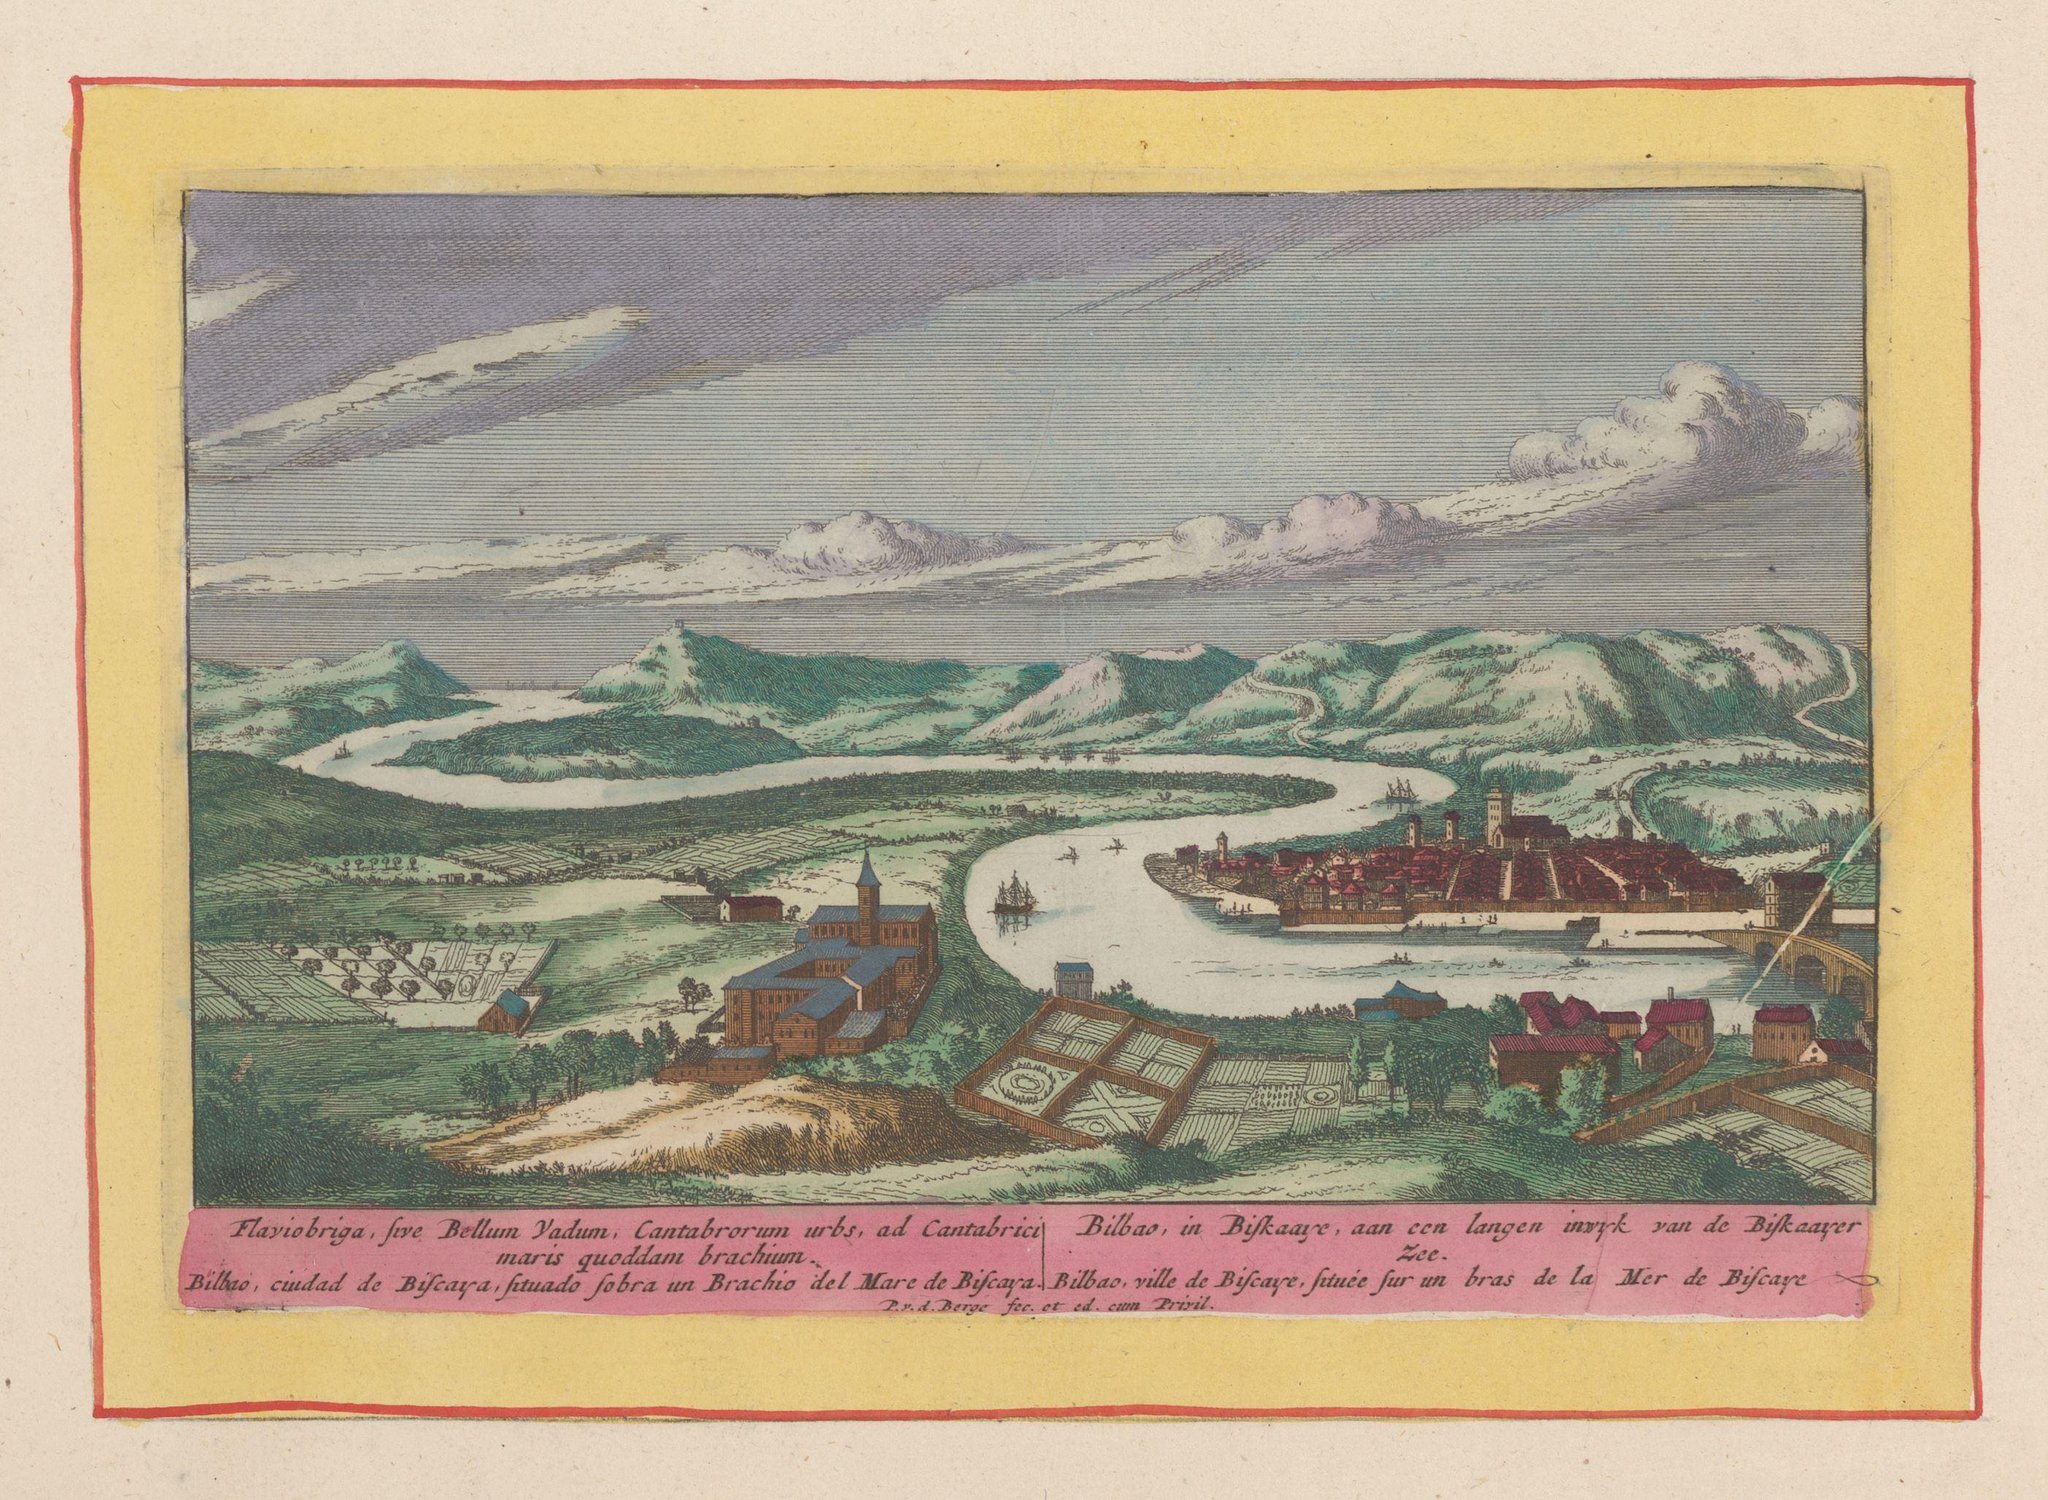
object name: book illustration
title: Bilbao, in Biskaaye, aan een langen inwyk van de Biskaayer Zee (...)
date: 1694-1737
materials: paper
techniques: etching, hand coloring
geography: the hague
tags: prospect of city, town panorama, silhouette of city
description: Prent uit: Theatrum Hispaniæ, exhibens regni urbes, villas ac viridaria magis illustria. Het aanmerkelykste en voortreffelykste in Spanjen (...). Amsterdam: Pieter van den Berge, ca. 1694-1737.